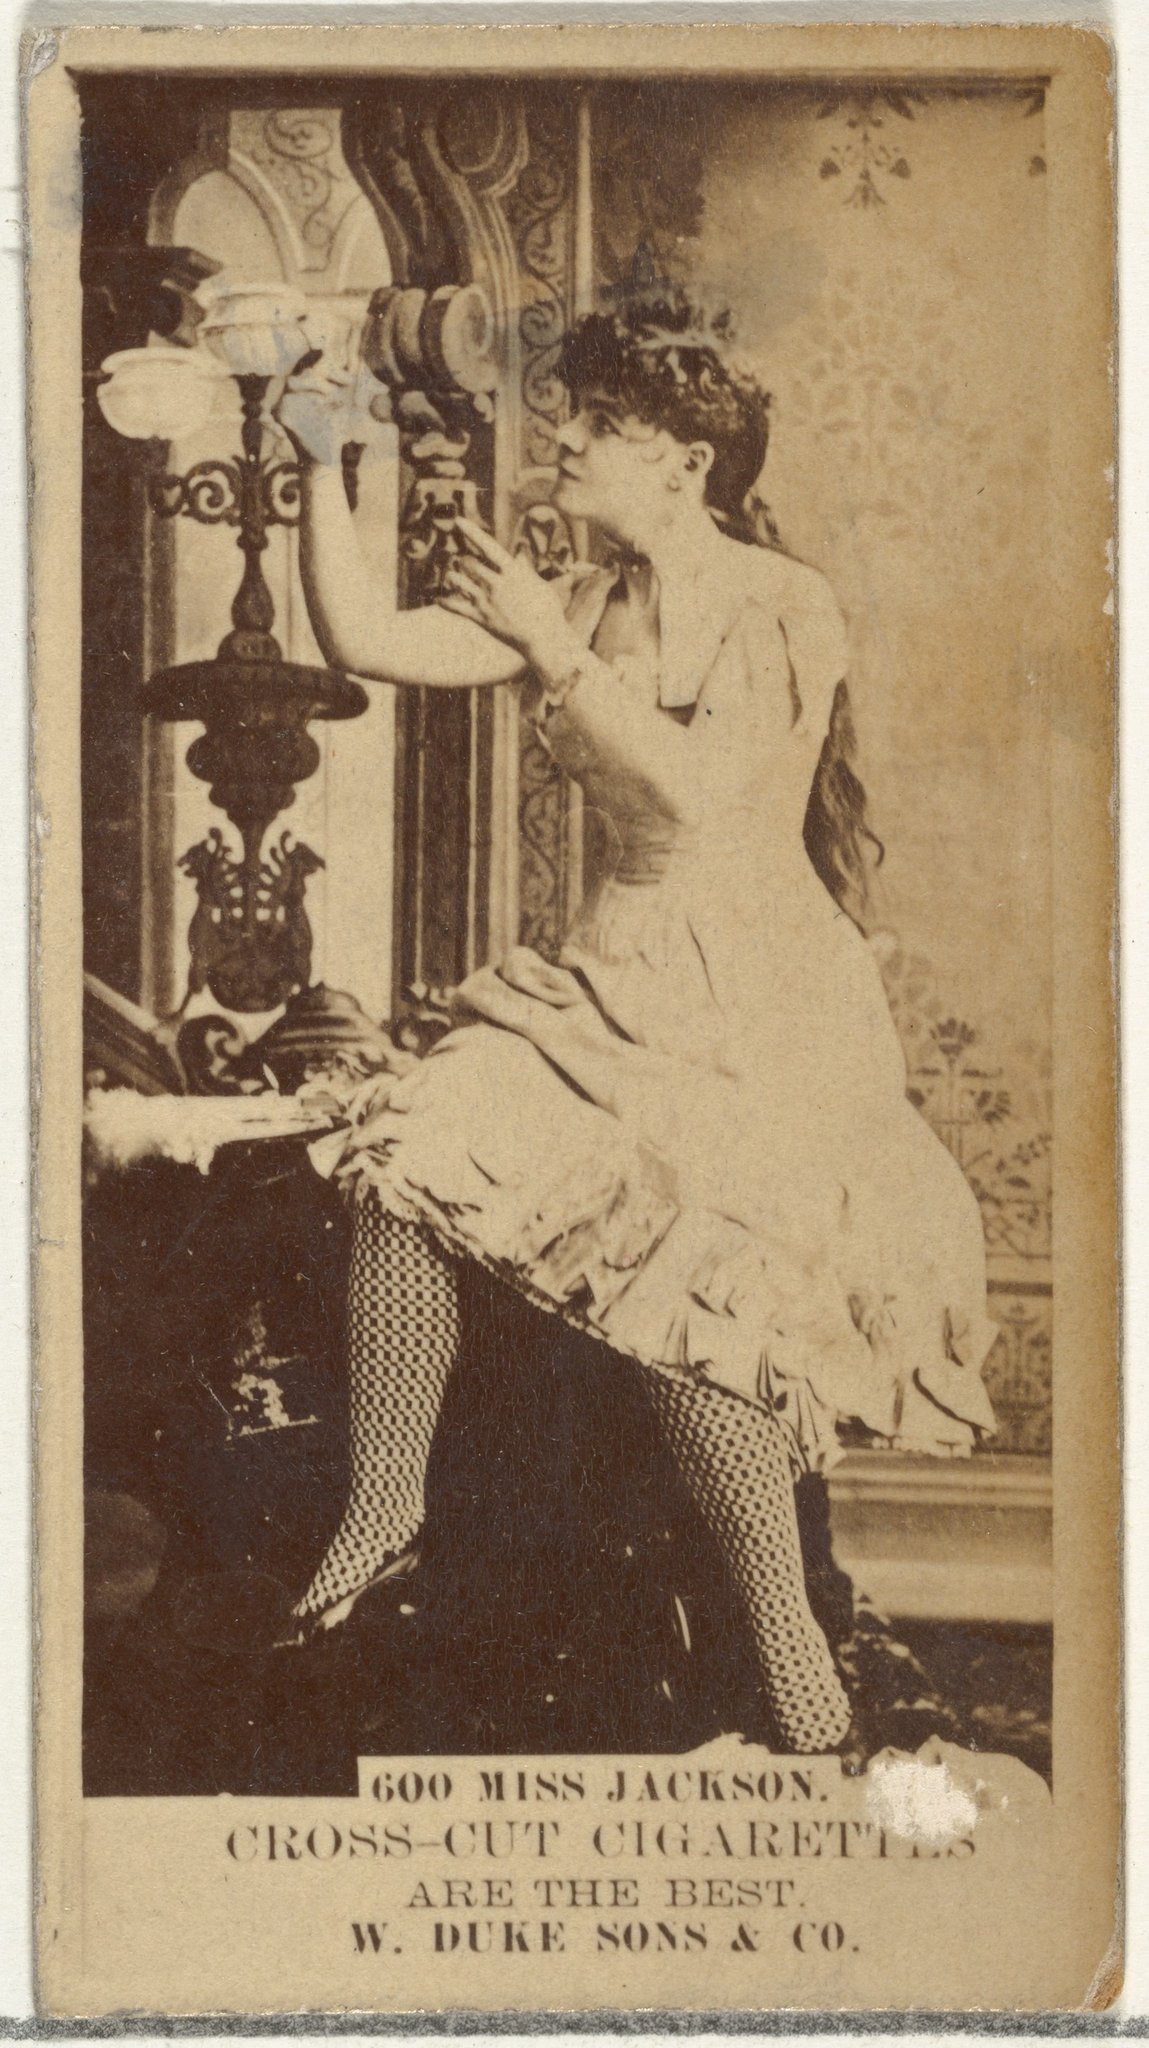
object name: photograph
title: Card Number 600, Miss Jackson, from the Actors and Actresses series (N145-3) issued by Duke Sons & Co. to promote Cross Cut Cigarettes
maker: w. duke, sons & co.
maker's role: publisher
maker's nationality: american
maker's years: 1870-1920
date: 1880-1889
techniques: albumen silver print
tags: profiles,women,actresses